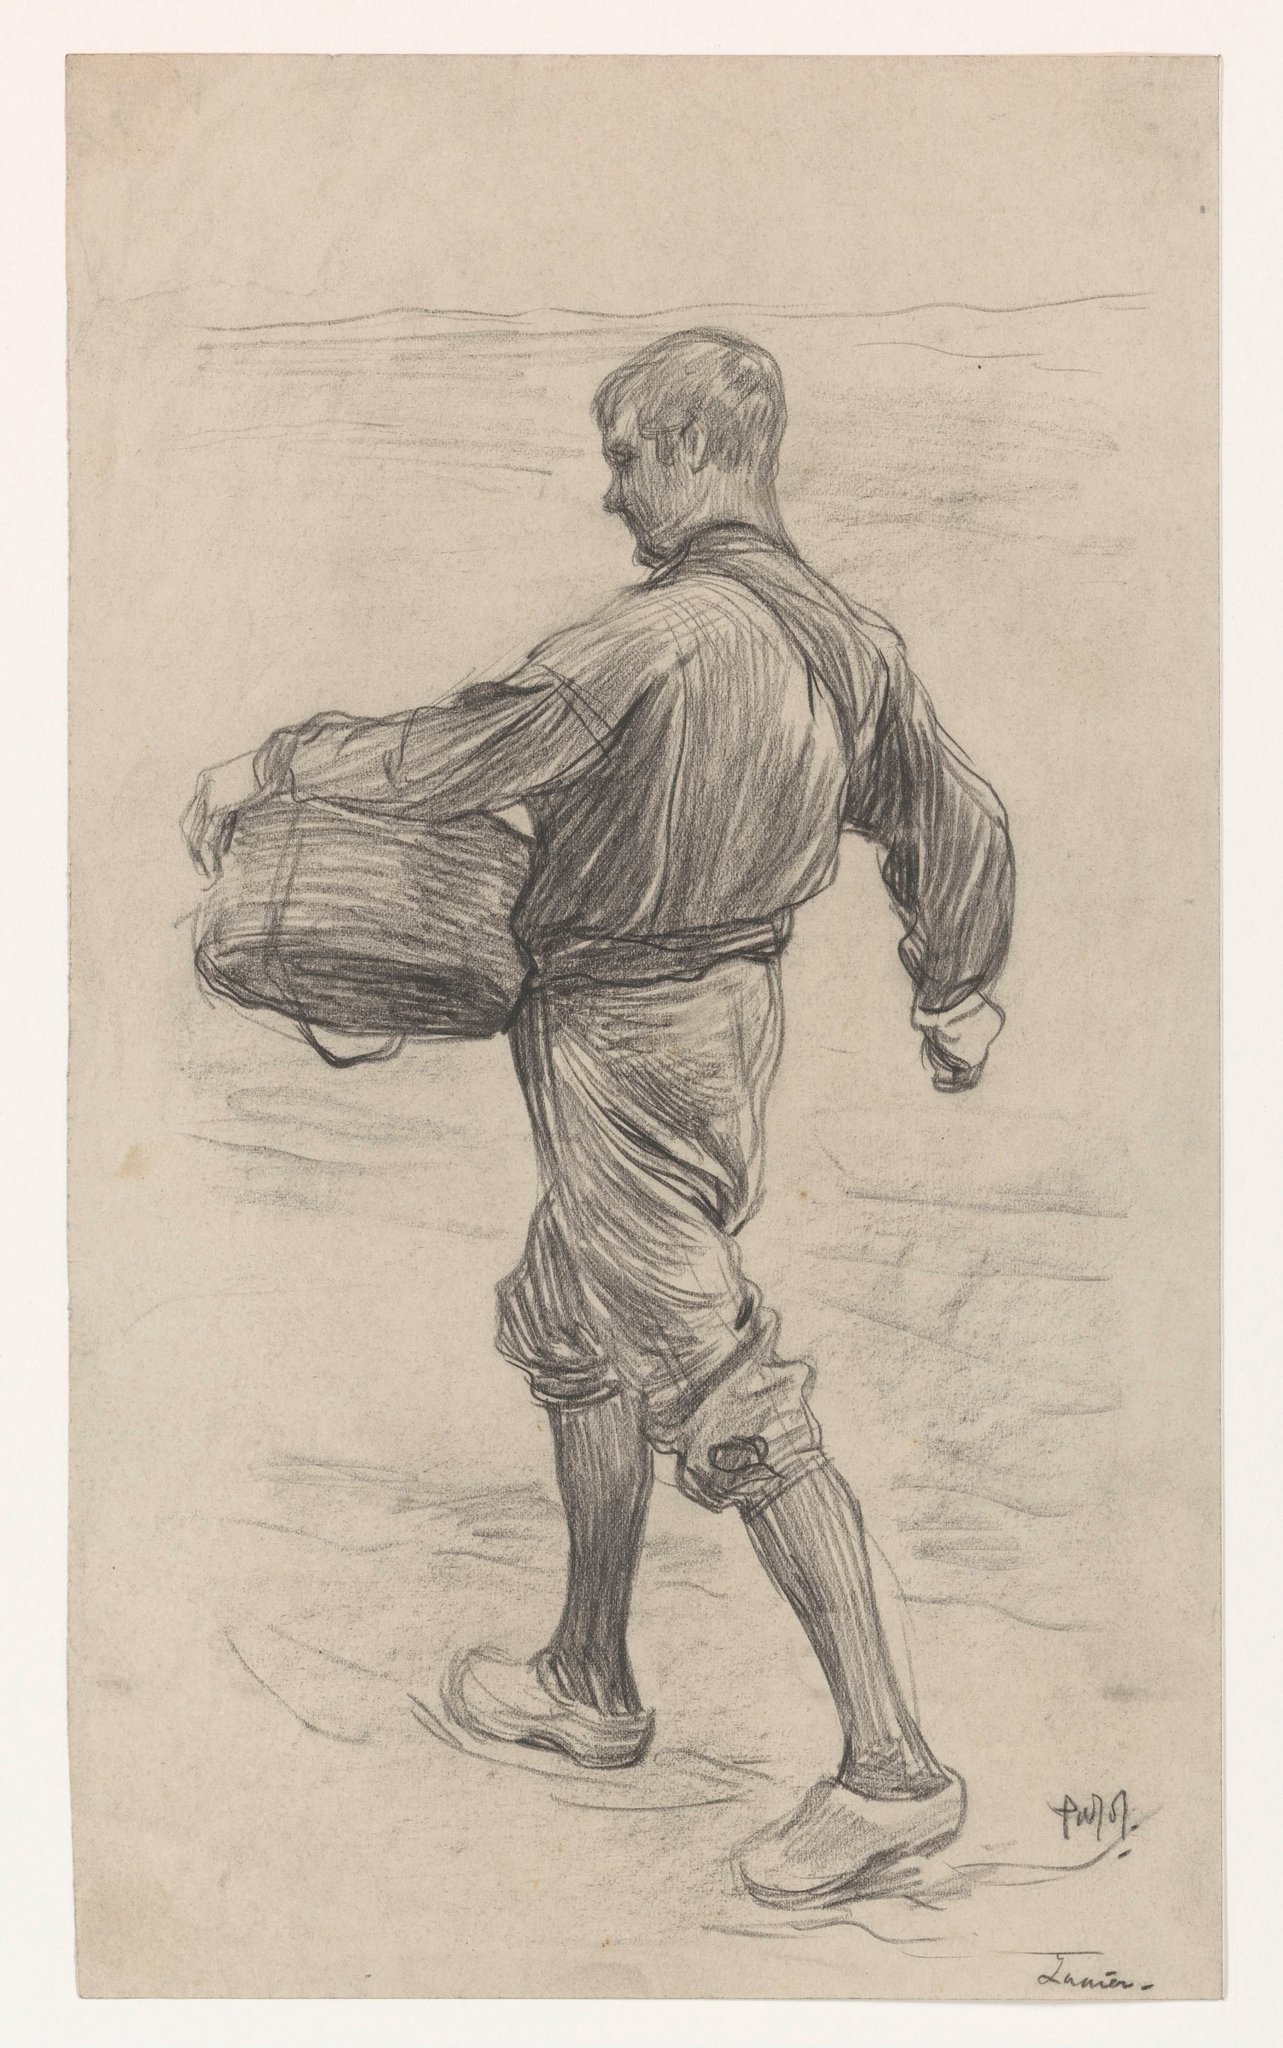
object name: drawing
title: Zaaier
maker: pieter de josselin de jong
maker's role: draughtsman, painter, print maker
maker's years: 1861-1906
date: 1871-1906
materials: chalk, paper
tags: sowing